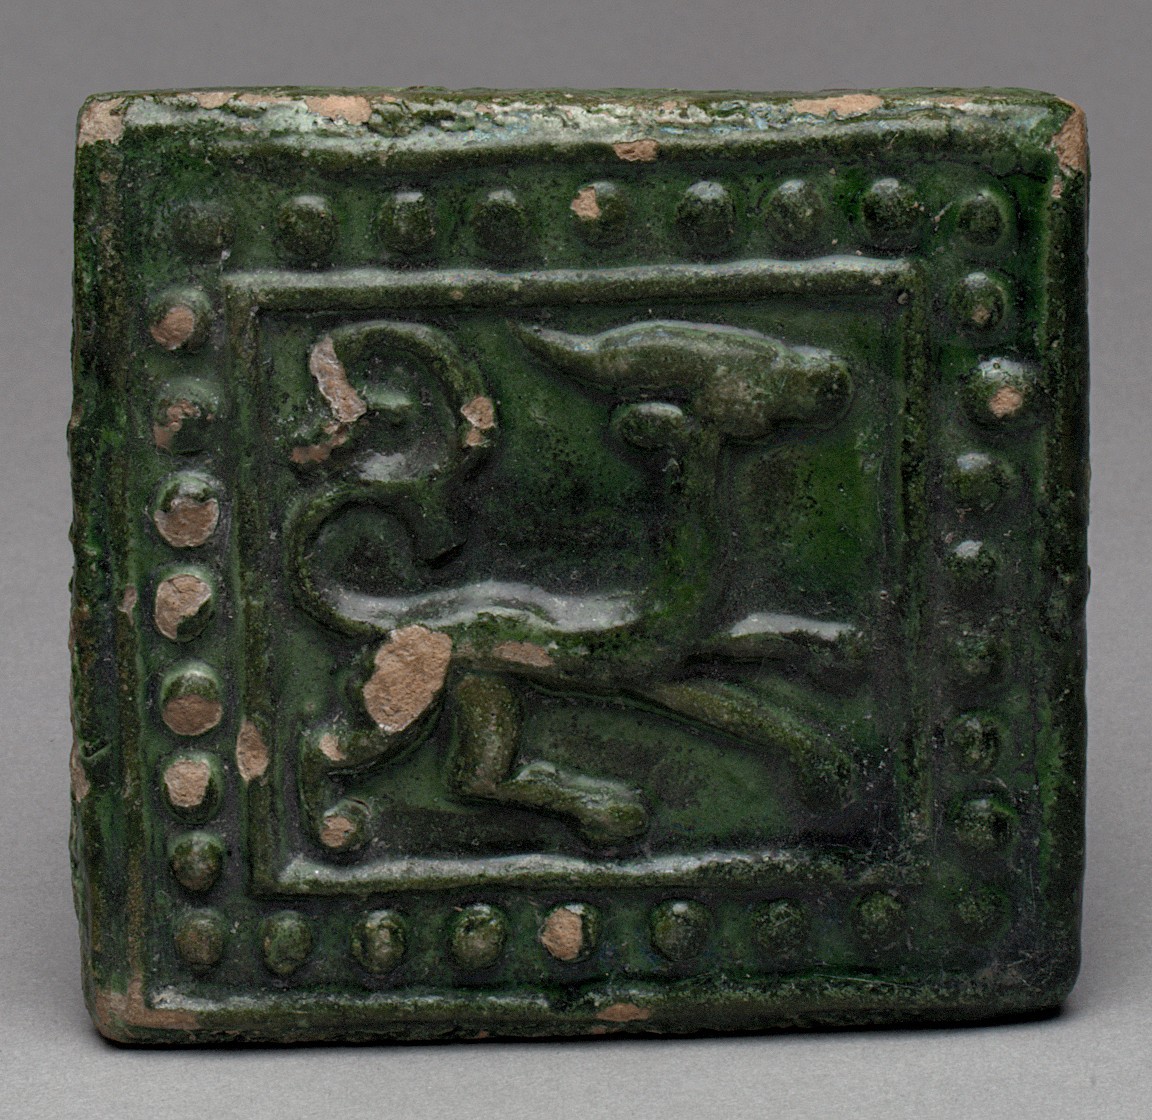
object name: tile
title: Square Tile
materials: earthenware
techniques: glazing, molding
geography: afghanistan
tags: animals